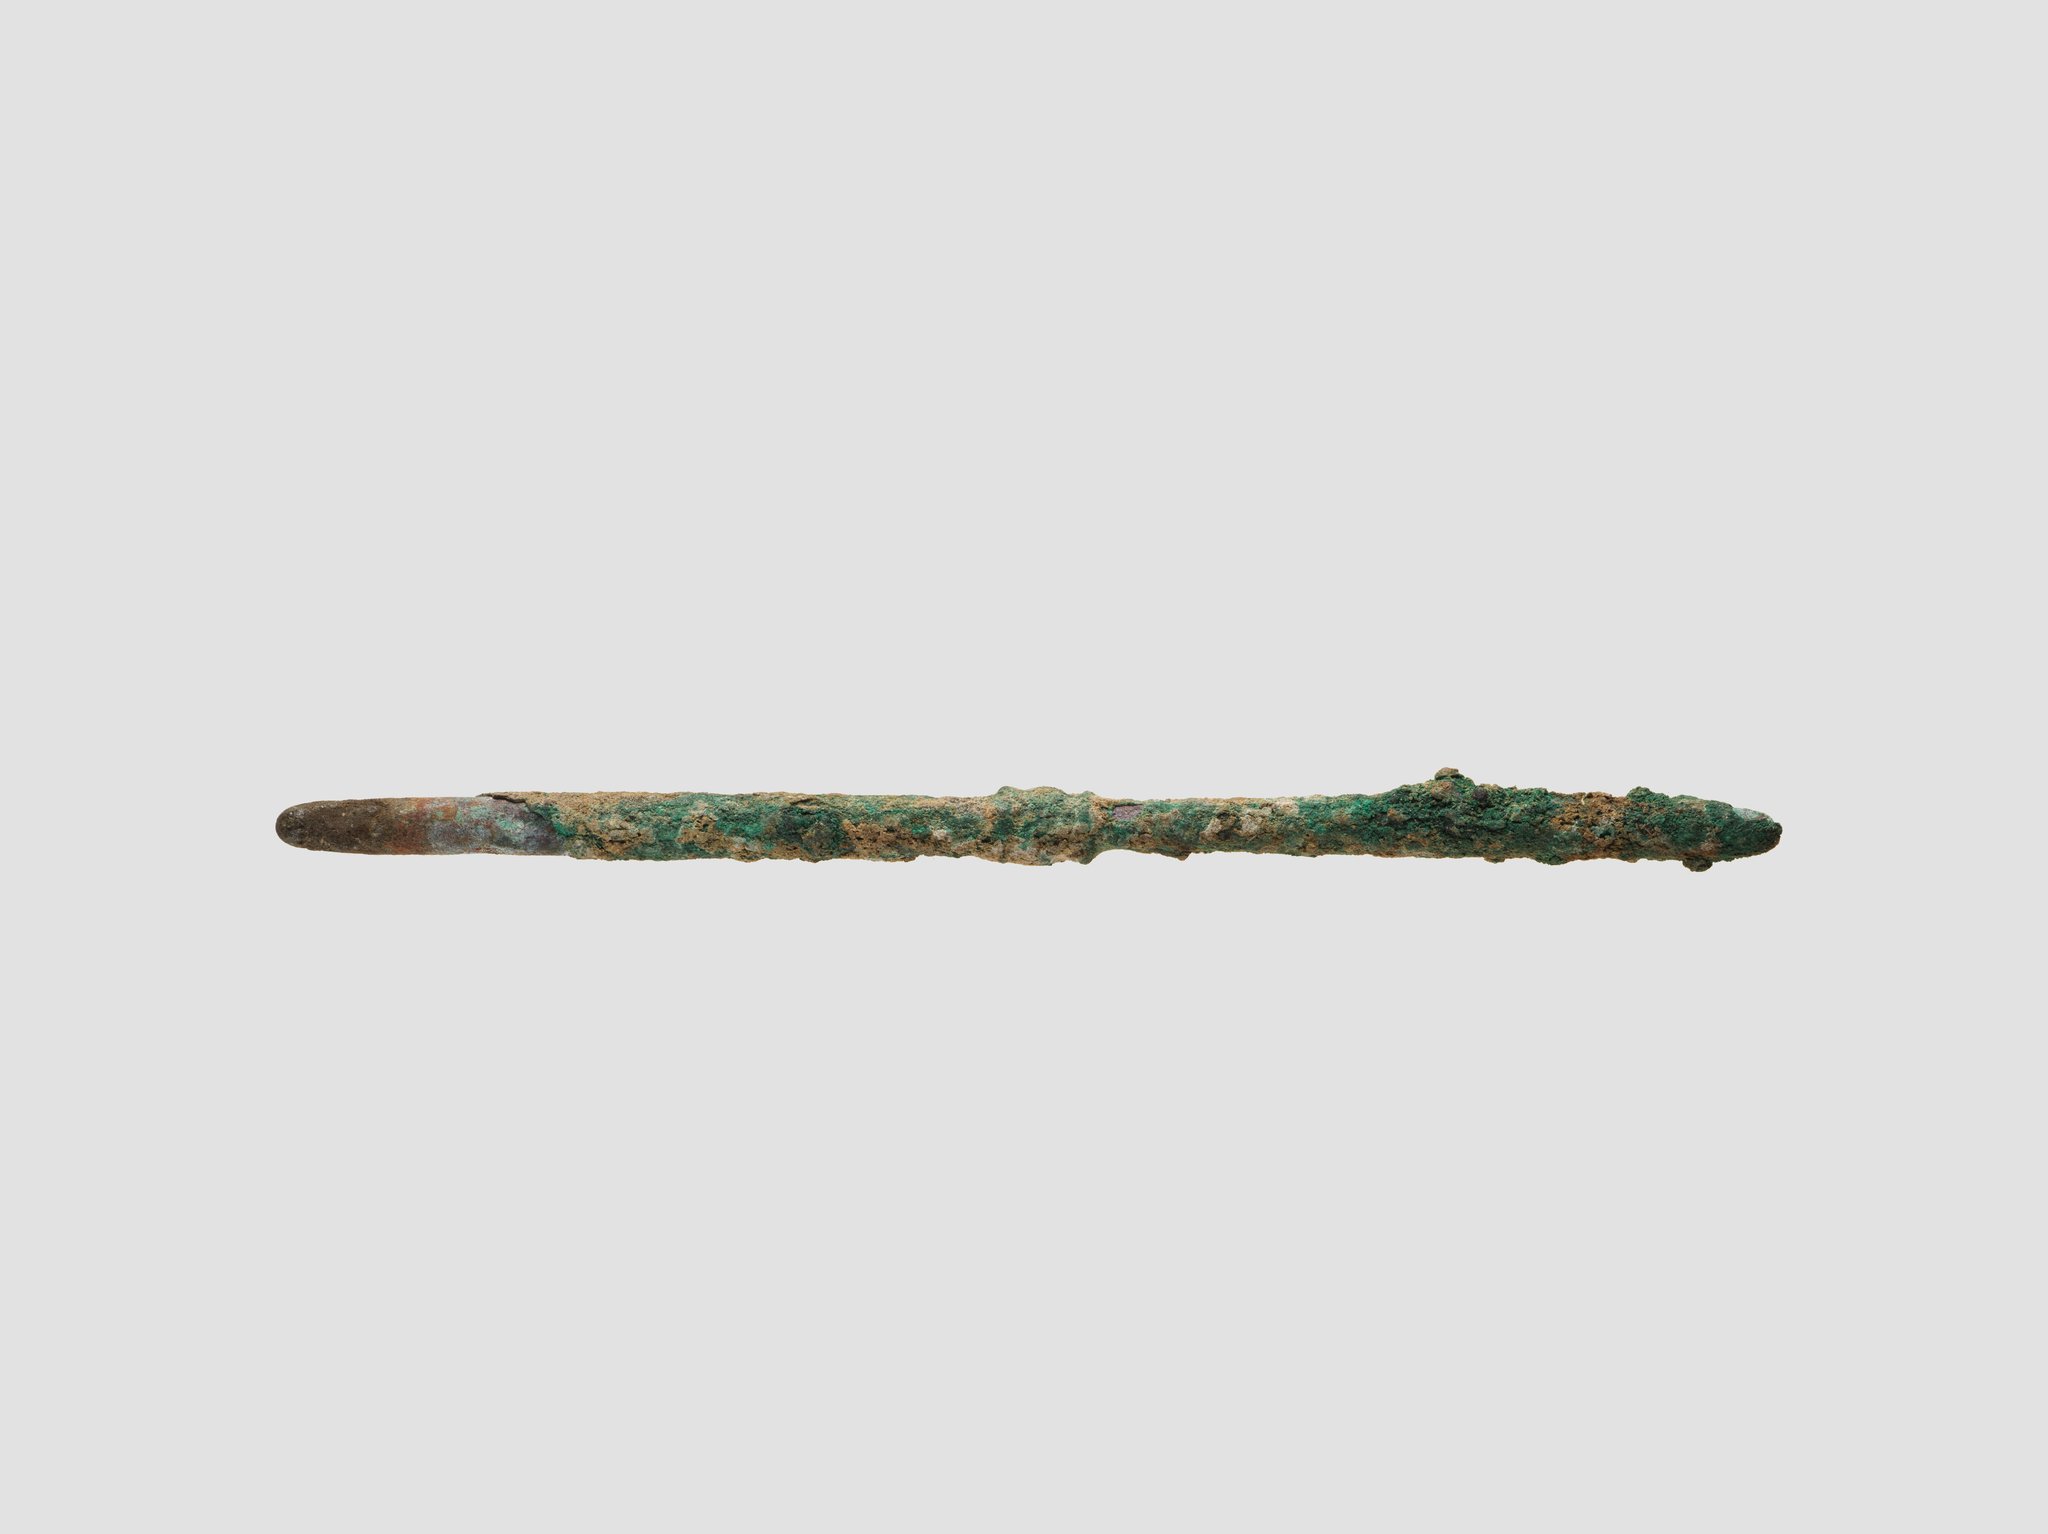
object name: cosmetic pencil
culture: sasanian or islamic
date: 501-800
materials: bronze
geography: mesopotamia